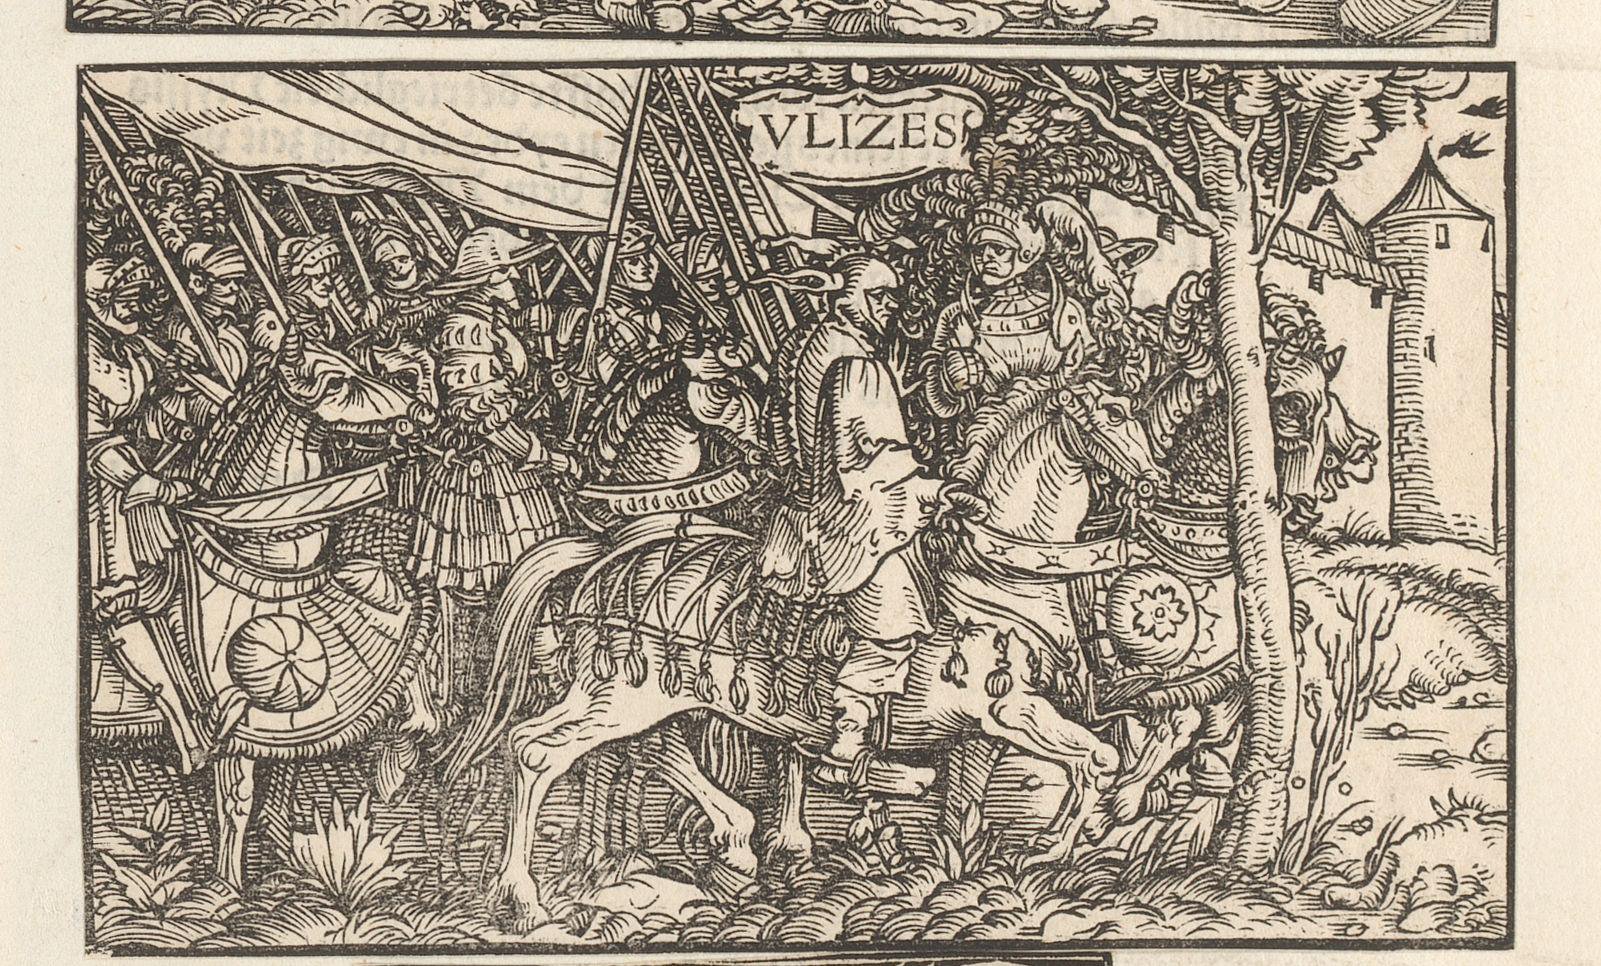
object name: book illustration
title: Odysseus als nar verkleed en zijn troepen bij een stadspoort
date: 1514-1531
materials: paper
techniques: letterpress printing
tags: (story of) ulysses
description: Deze prent is gebruikt in: Cicero, Marcus Tulius. Officia M.T.C. Ein Buch so Marcus Tullius Cicero der Römer zu seynem (...). [Vertaald uit het Latijn door] Johann von Schwarzenberg. Augsburg: Heinrich Steiner, 1531.